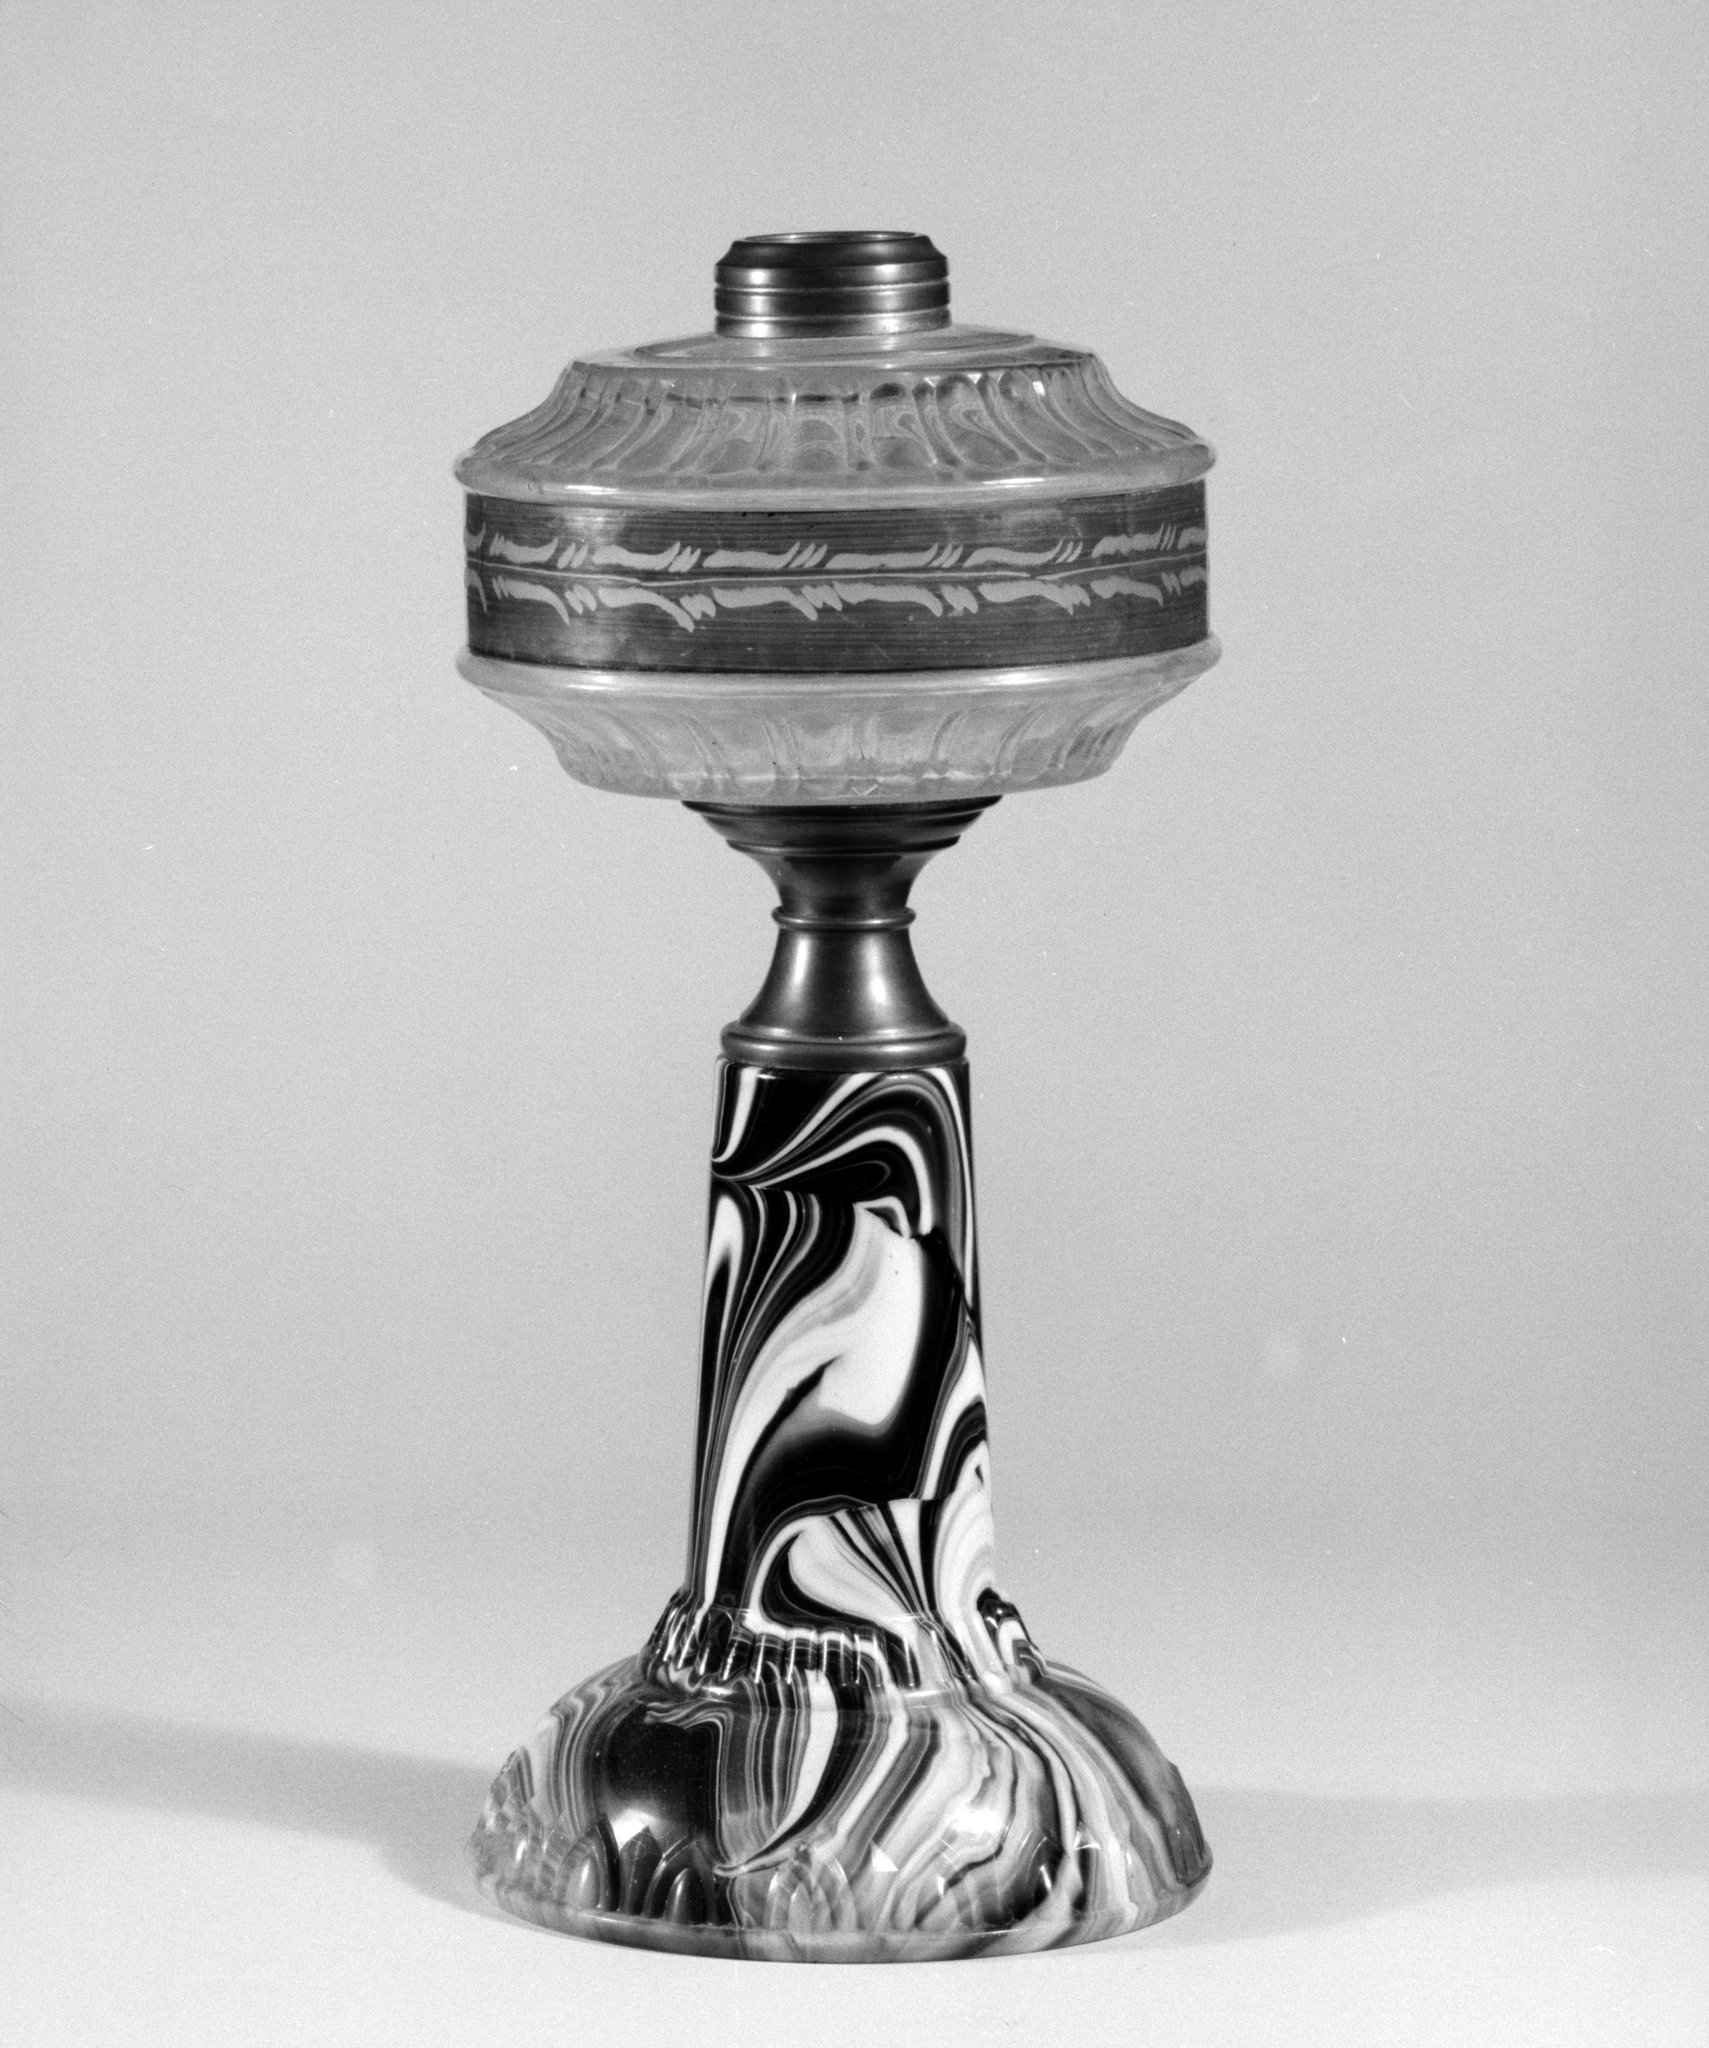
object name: lamp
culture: american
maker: challinor, taylor and company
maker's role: maker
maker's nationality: american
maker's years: 1866-1891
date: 1870-1890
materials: glass, marble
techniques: pressed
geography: united states